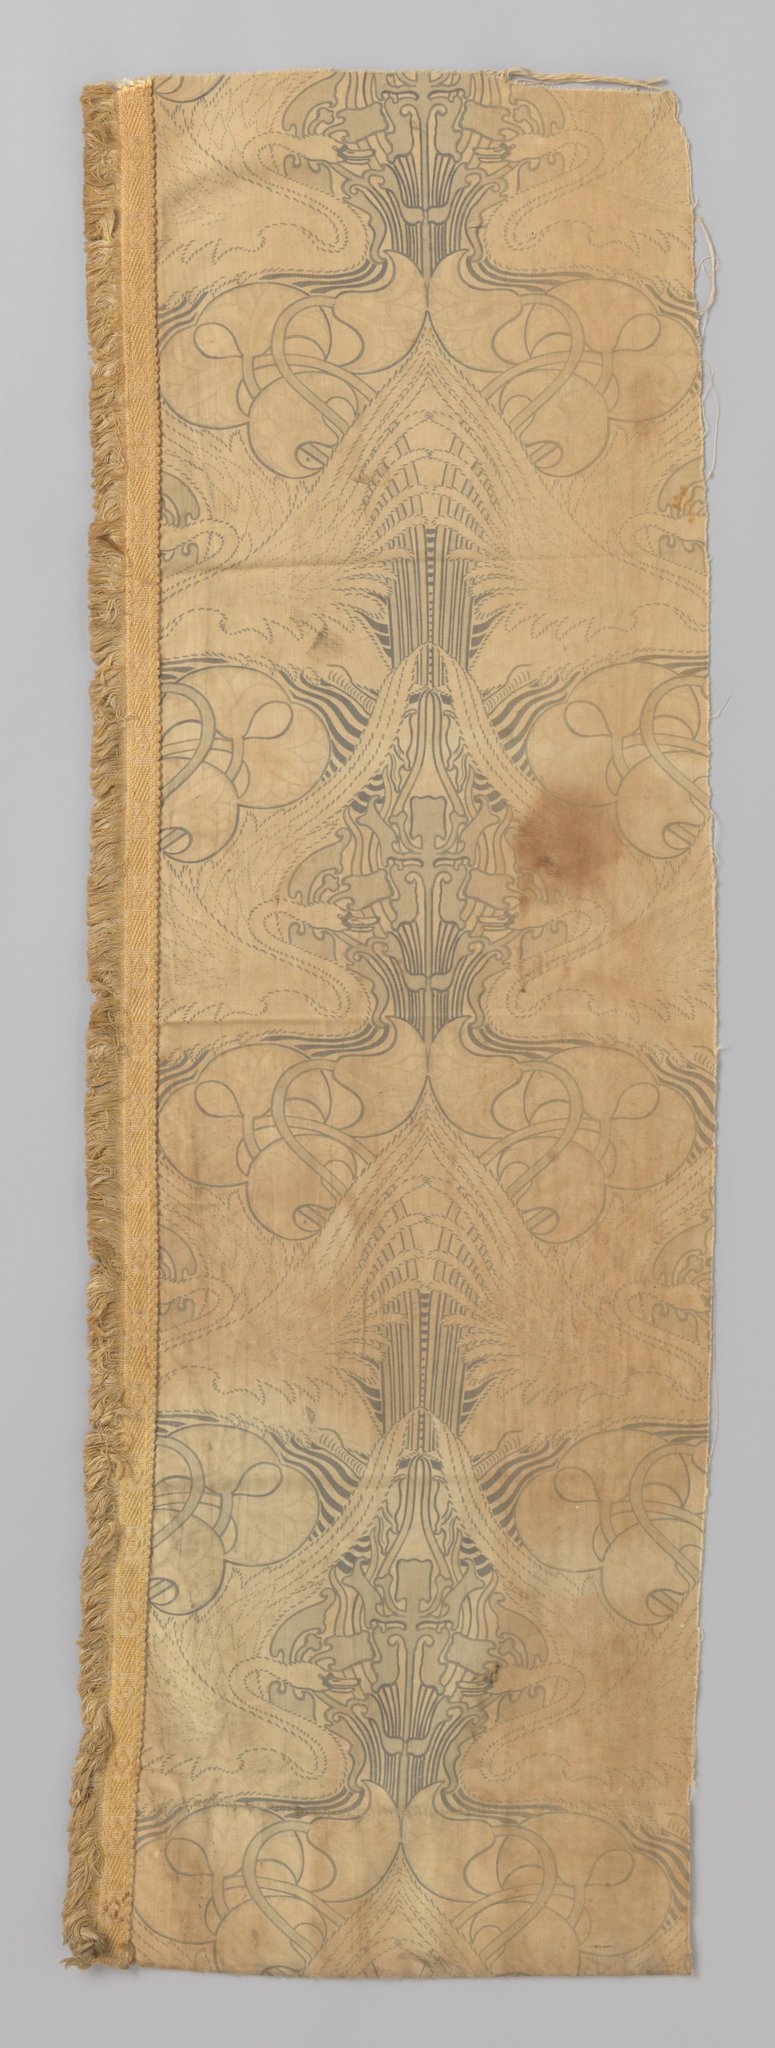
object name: fragment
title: Fragment van een overgordijn van bedrukte cretonne met zwanen en lissen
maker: michiel duco crop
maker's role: designer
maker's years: 1862-1901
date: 1900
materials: linen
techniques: printing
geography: helmond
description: Fragment van een overgordijn van bedrukte cretonne met zwanen en lissen.